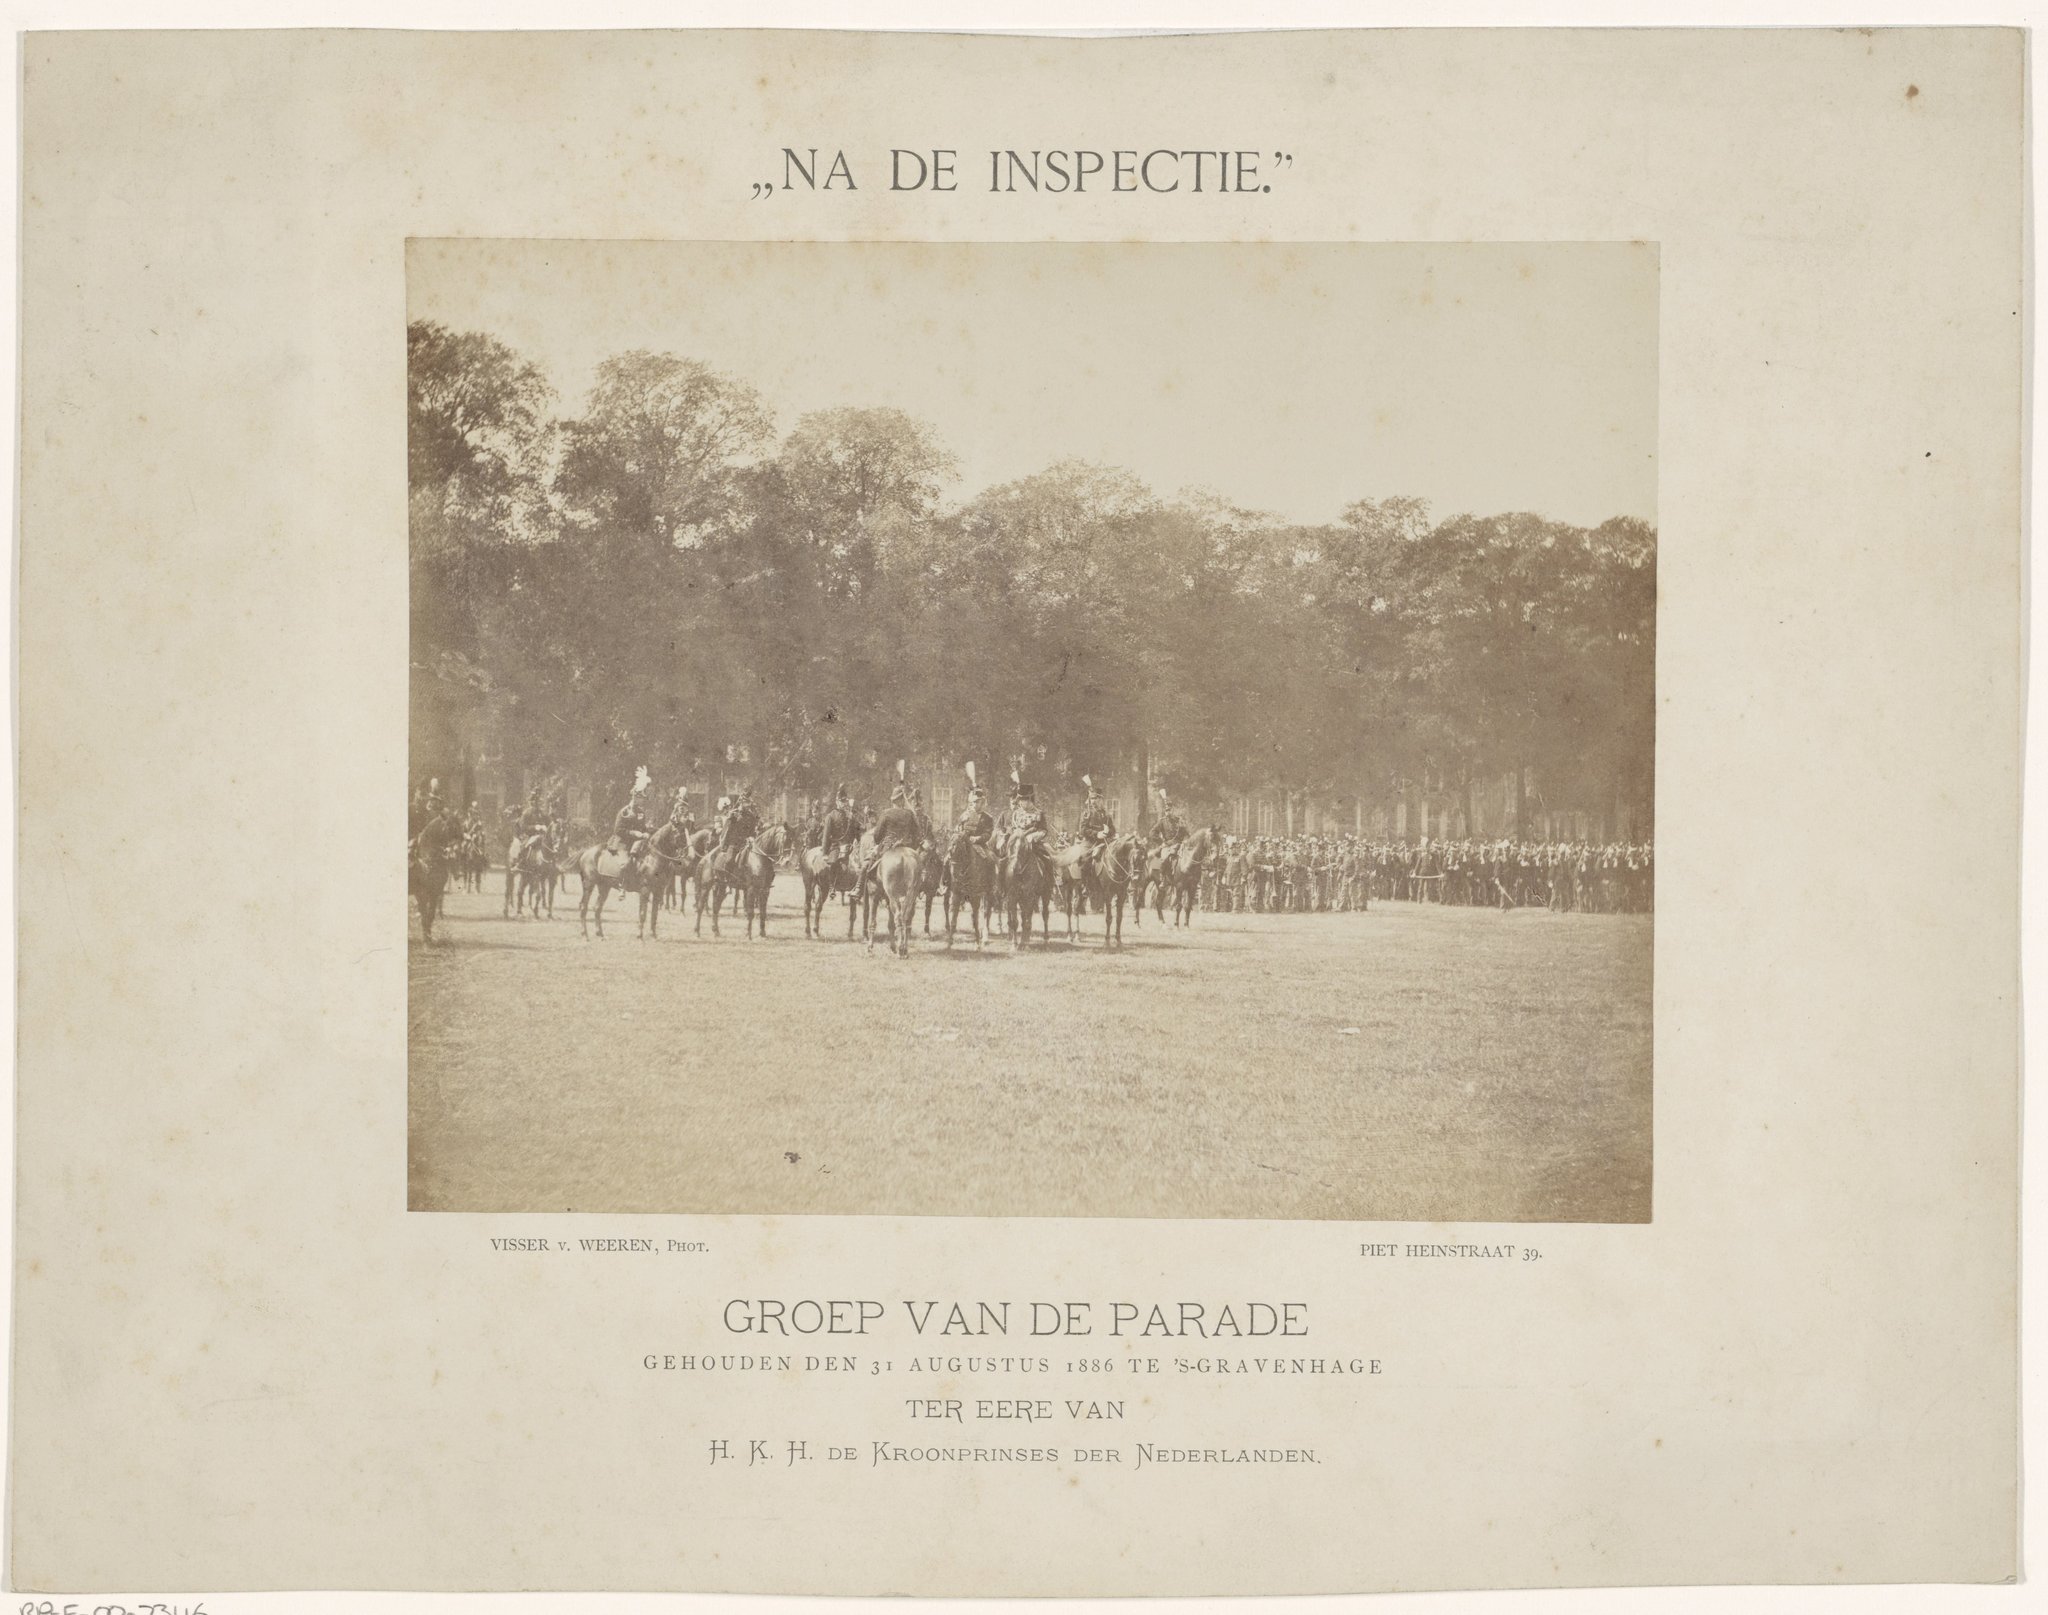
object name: photograph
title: Groep van de parade ter ere van van Wilhelmina, koningin der Nederlanden, te Den Haag op 31 augustus 1886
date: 1886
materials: cardboard, paper, photographic support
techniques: albumen print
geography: the hague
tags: print maker, wilhelmina of the netherlands, the hague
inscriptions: address: ‘A. DONA MAGAZIJN VAN KANTOOR-, SCHRIJF- en TEEKENBEHOEFTEN Piet Heinstraat 31 'S GRAVENHAGE.’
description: Groep van de parade ter ere van van Wilhelmina te Den Haag op 31 augustus 1886. In de bovenmarge '"NA DE INSPECTIE"'. In de ondermarge vier regels Nederlandse tekst.